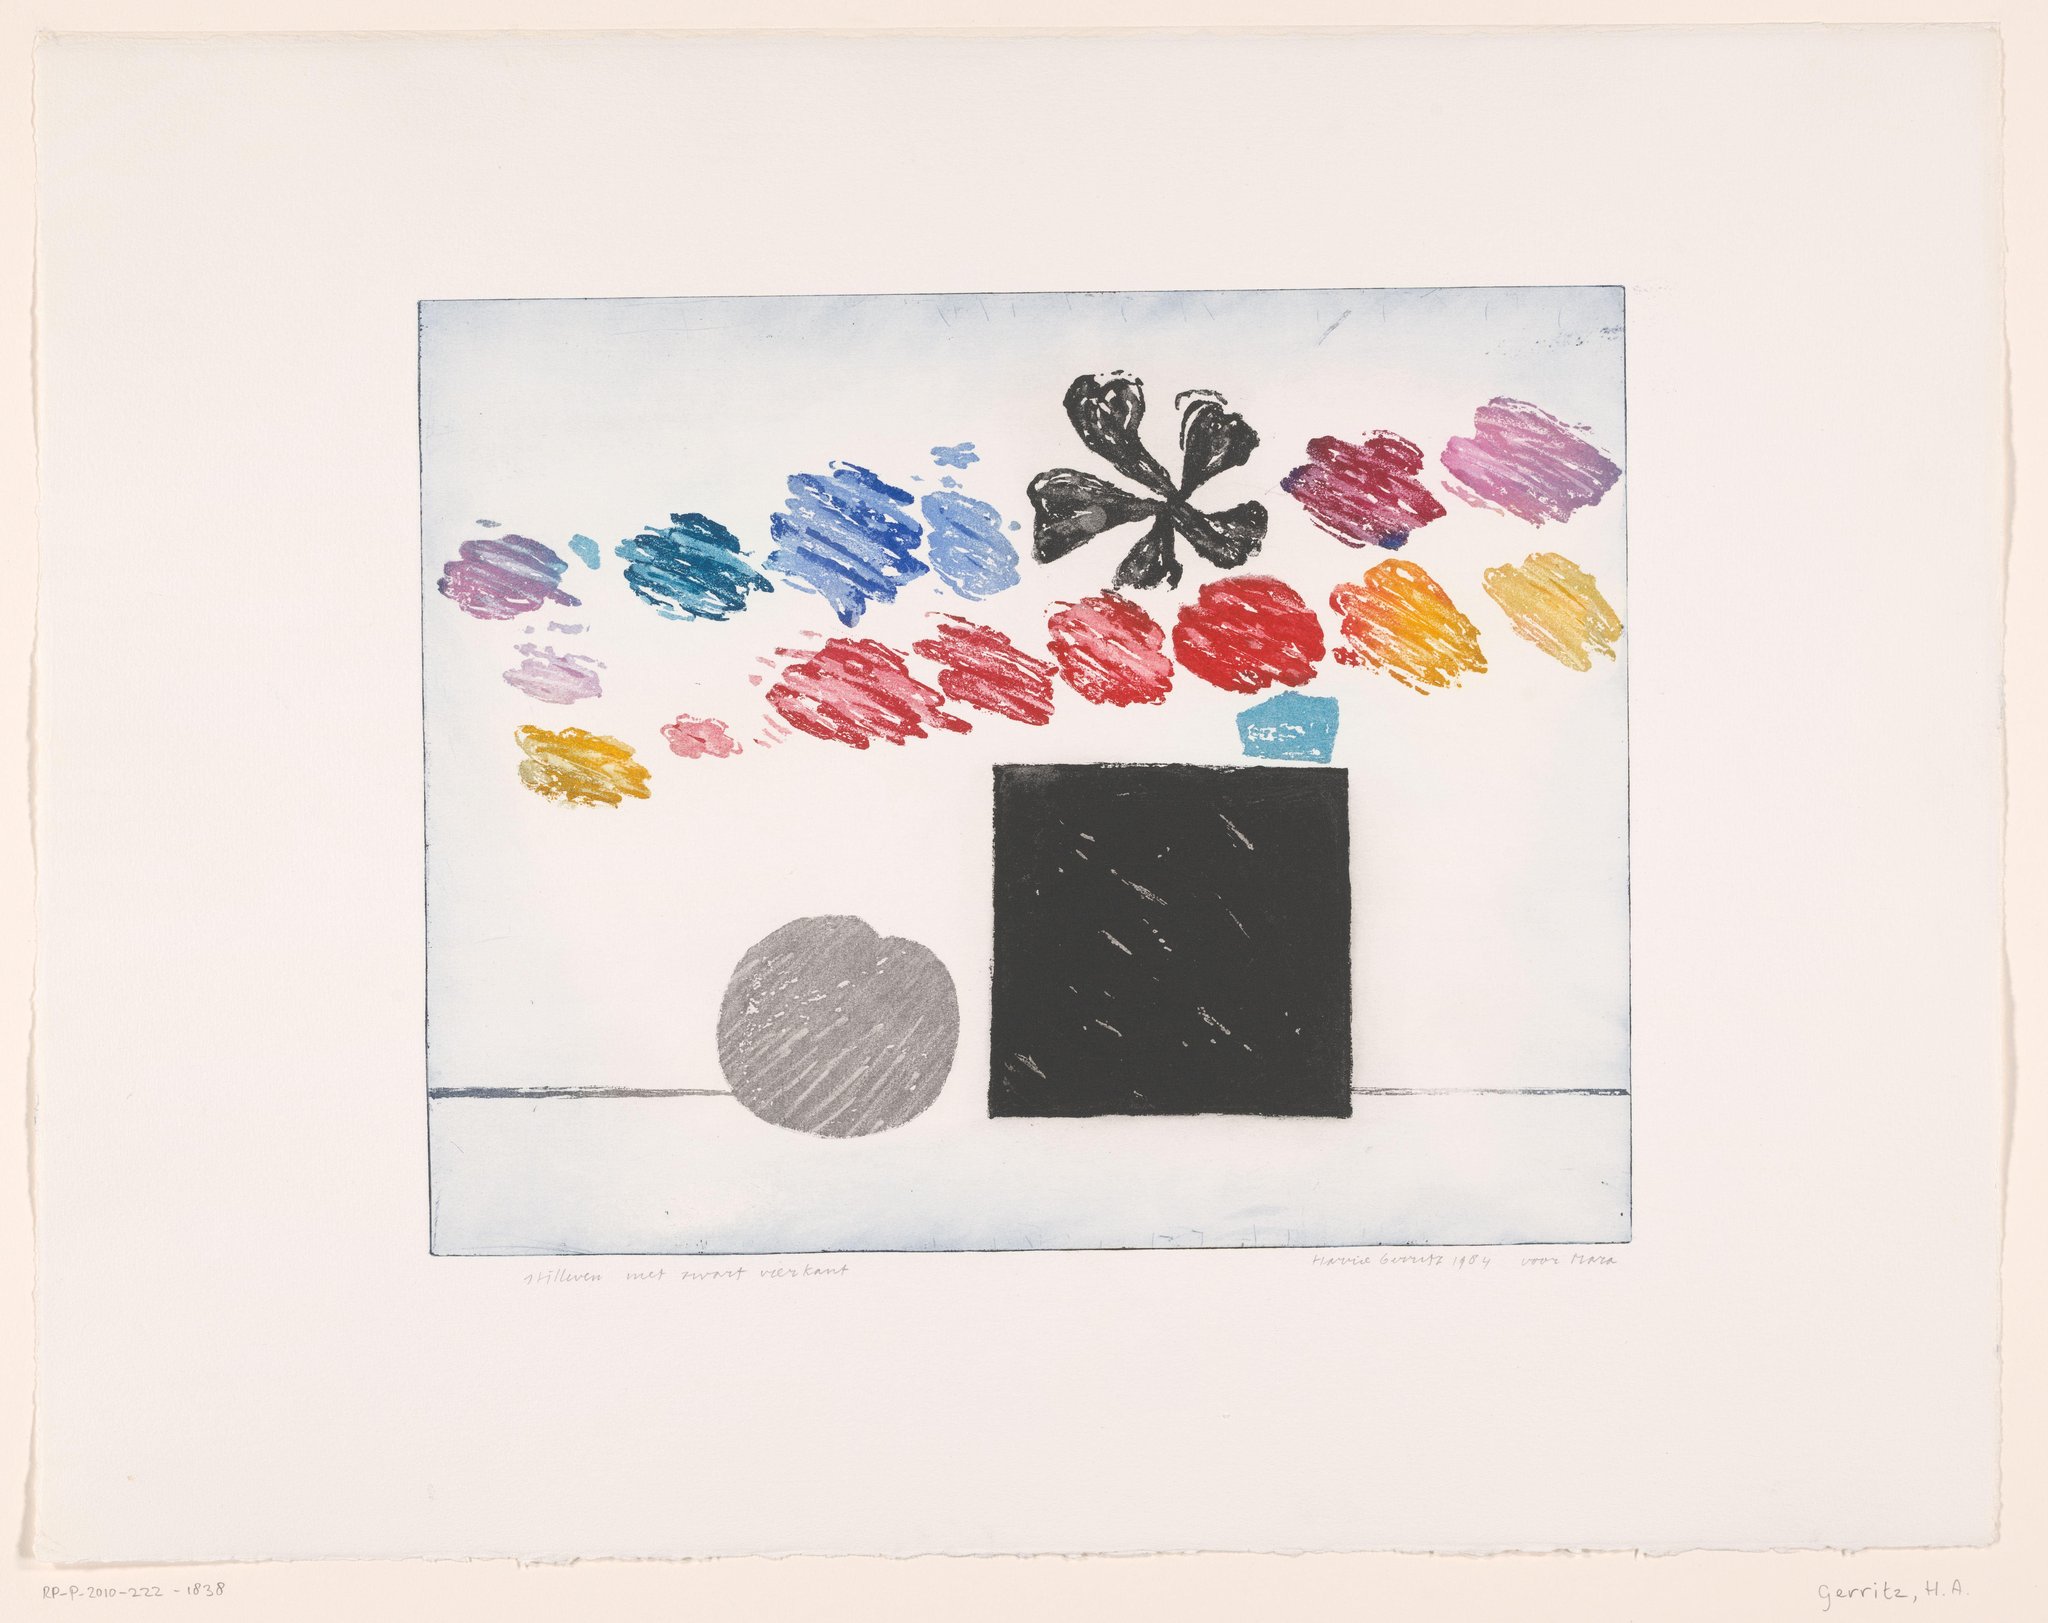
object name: print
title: Stilleven met zwart vierkant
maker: harrie a. gerritz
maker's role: draughtsman, painter, print maker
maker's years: 1940-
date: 1984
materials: paper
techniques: aquatint, intaglio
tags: abstract, non-representational art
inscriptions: dedication: ‘voor Mara’, collector's mark: Lugt 2228, inscription: ‘PC’